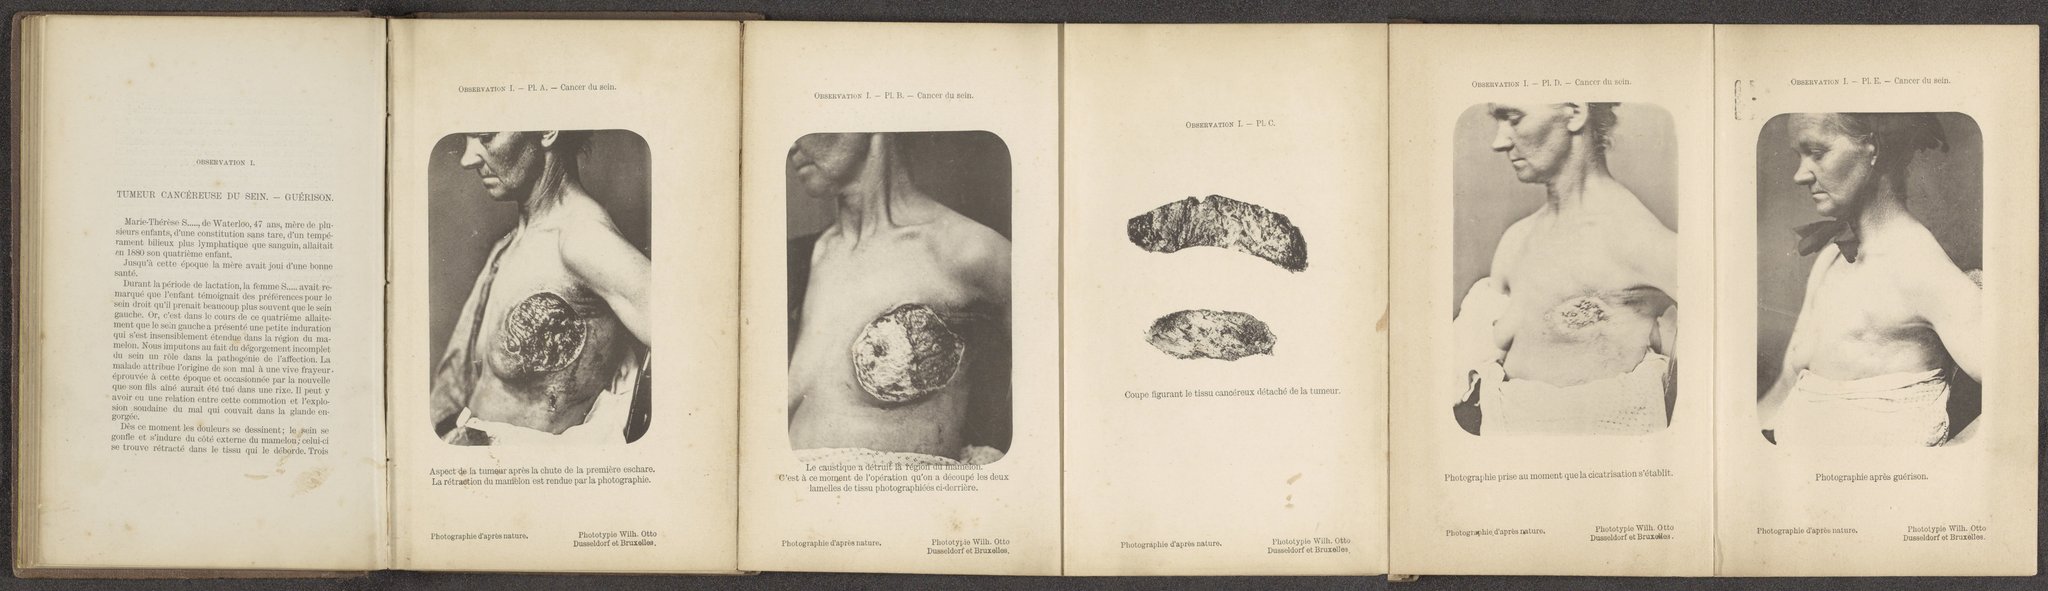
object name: page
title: Vrouw met opengesneden borsttumor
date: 1874-1884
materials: paper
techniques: photograph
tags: tumours - aa - female human figure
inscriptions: inscription: ‘Observation I. - Pl. B. - Cancer du sein. / Le caustitique a détruit la region du mamelon./ C'est à ce moment de l'opération (...)’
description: Onderdelen 2 tot en met 6 vormen een leporello.